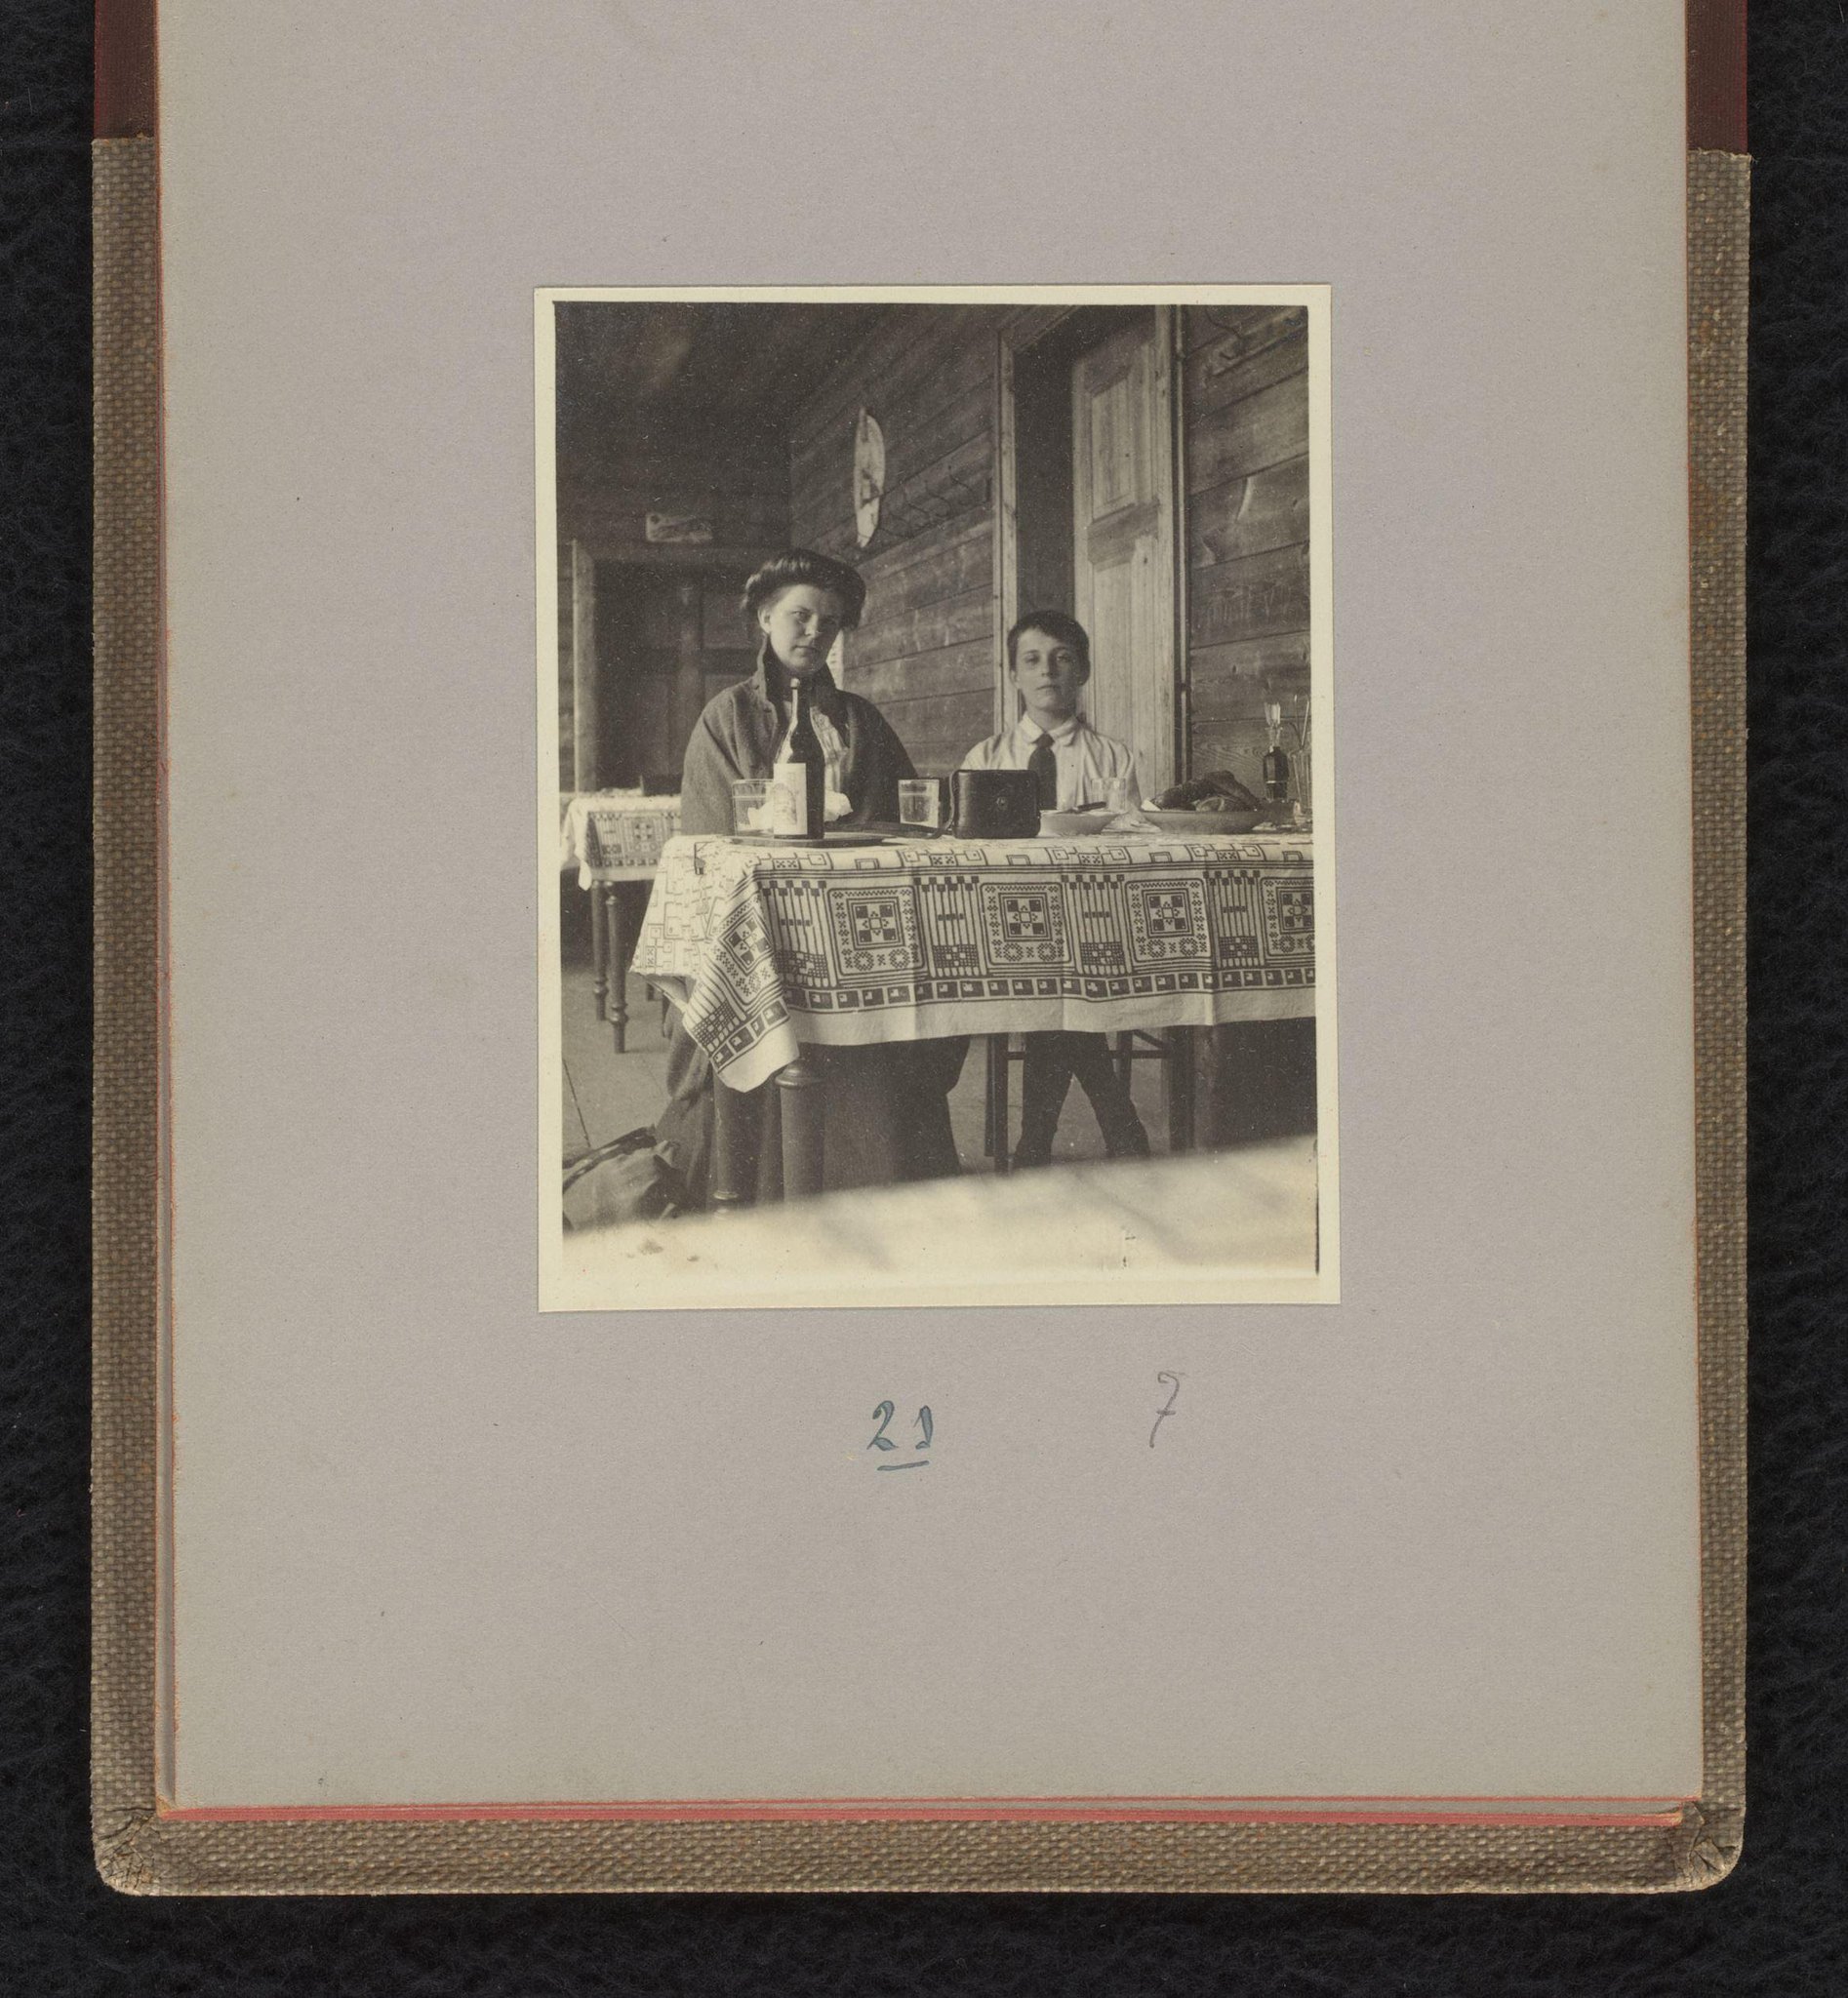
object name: album leaf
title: Go en Boelie Kessler aan een tafel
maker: johan herman kessler (jan)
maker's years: 1892-1978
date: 1910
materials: paper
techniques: gelatin silver print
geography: bavaria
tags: the hague, hermann johannes kessler (boelie), midday meal, lunch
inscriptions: number: ‘21’